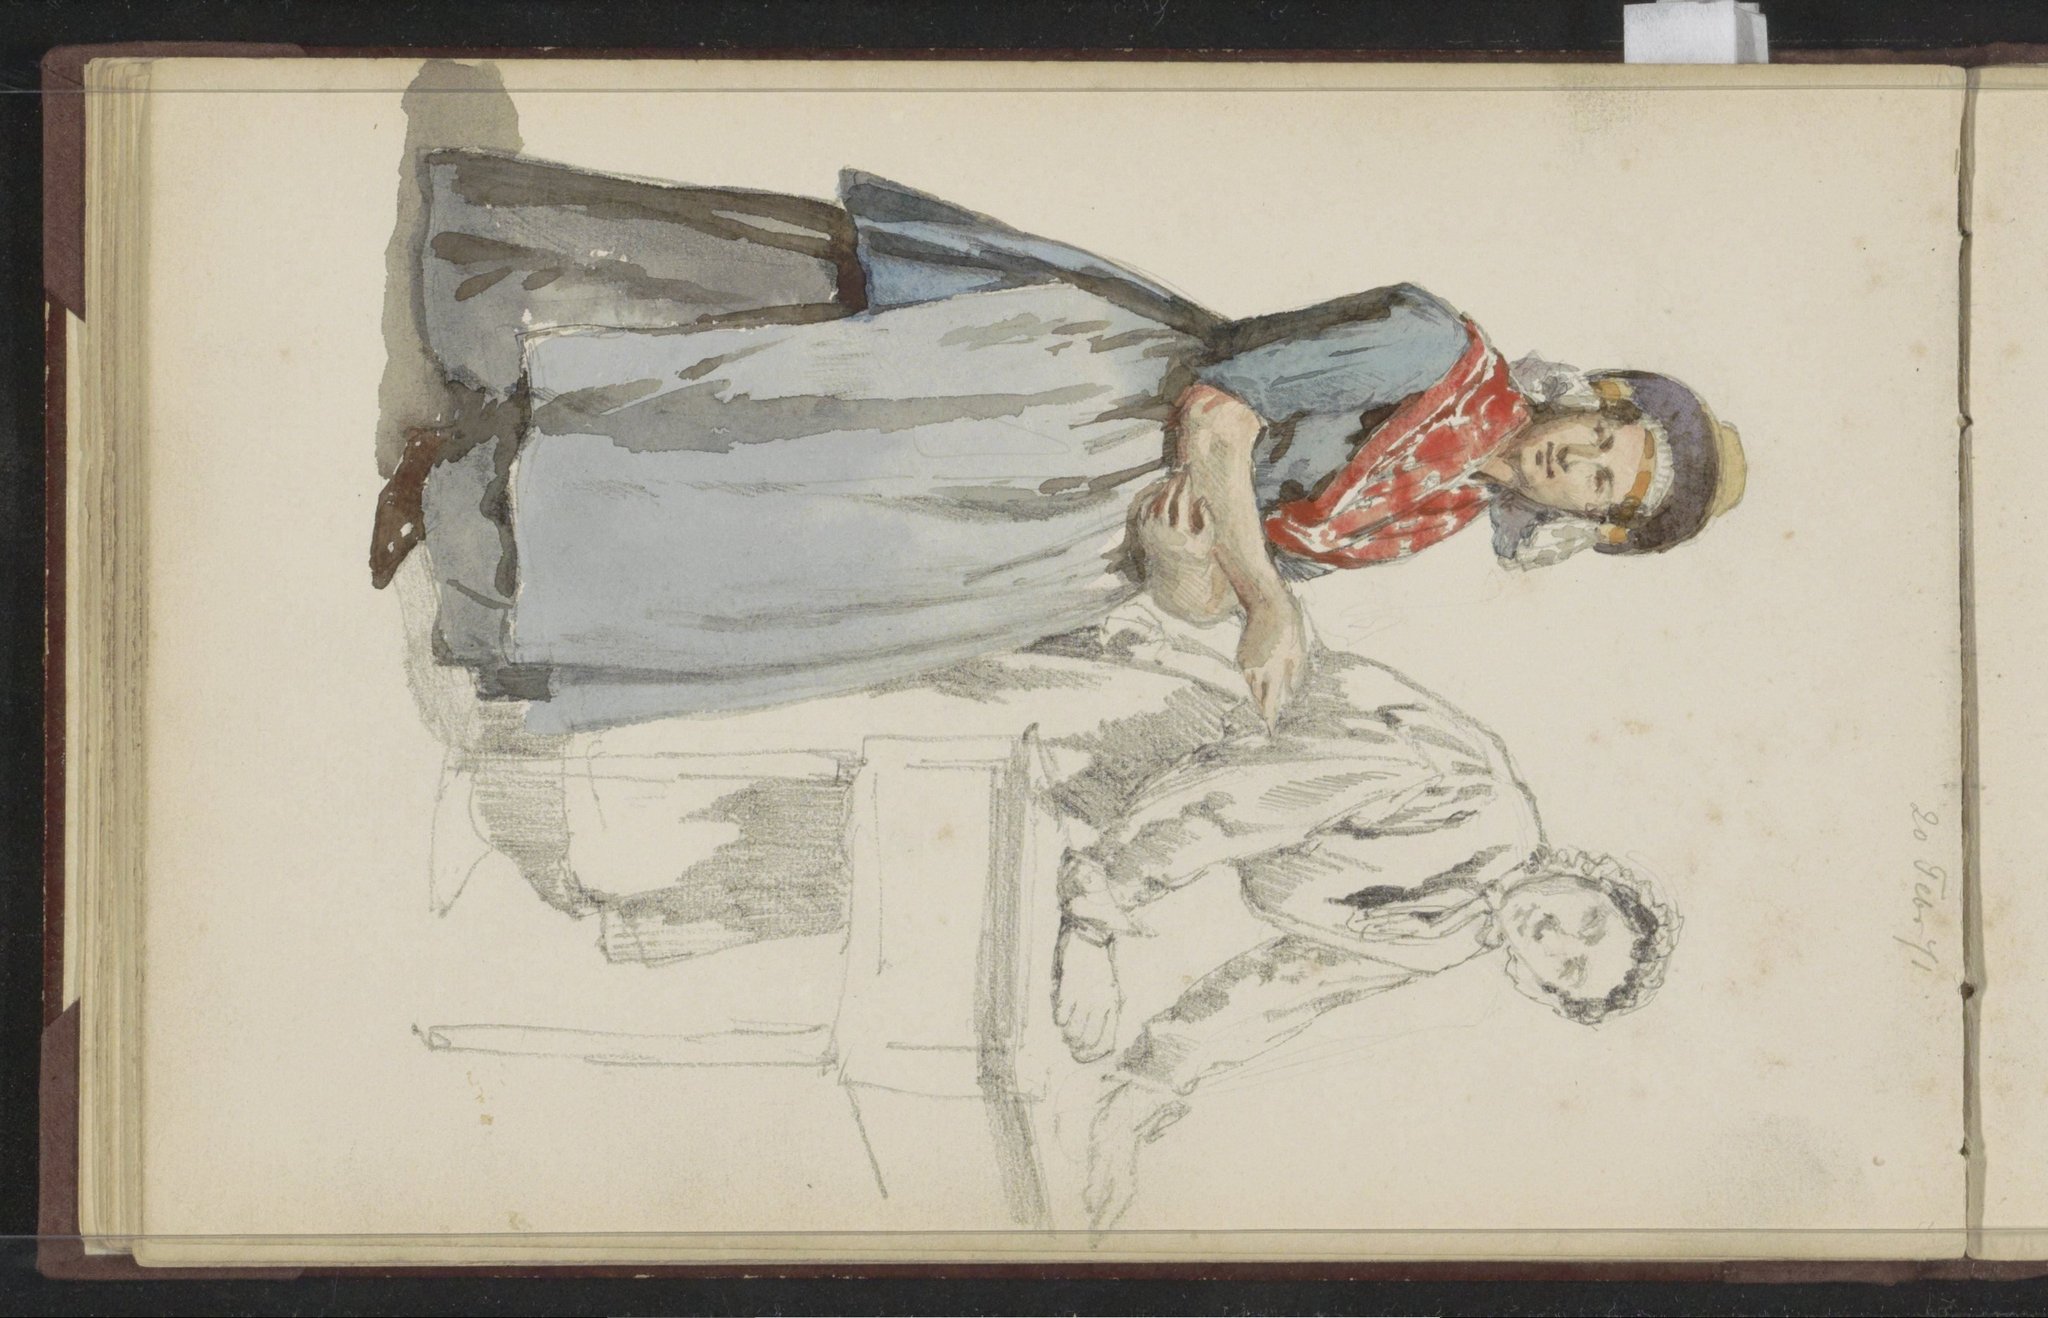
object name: sketchbook leaf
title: Twee vrouwen bij een tafel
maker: cornelis springer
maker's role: draughtsman, painter, print maker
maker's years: 1817-1891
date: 1871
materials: paper, pencil, watercolor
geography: netherlands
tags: table, adult woman (+ two persons)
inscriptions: date: ‘20 Febr 71’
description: Twee vrouwen bij een tafel. Blad 16 verso uit een schetsboek met 39 bladen, deels vervaardigd te Ulm en Leiden.